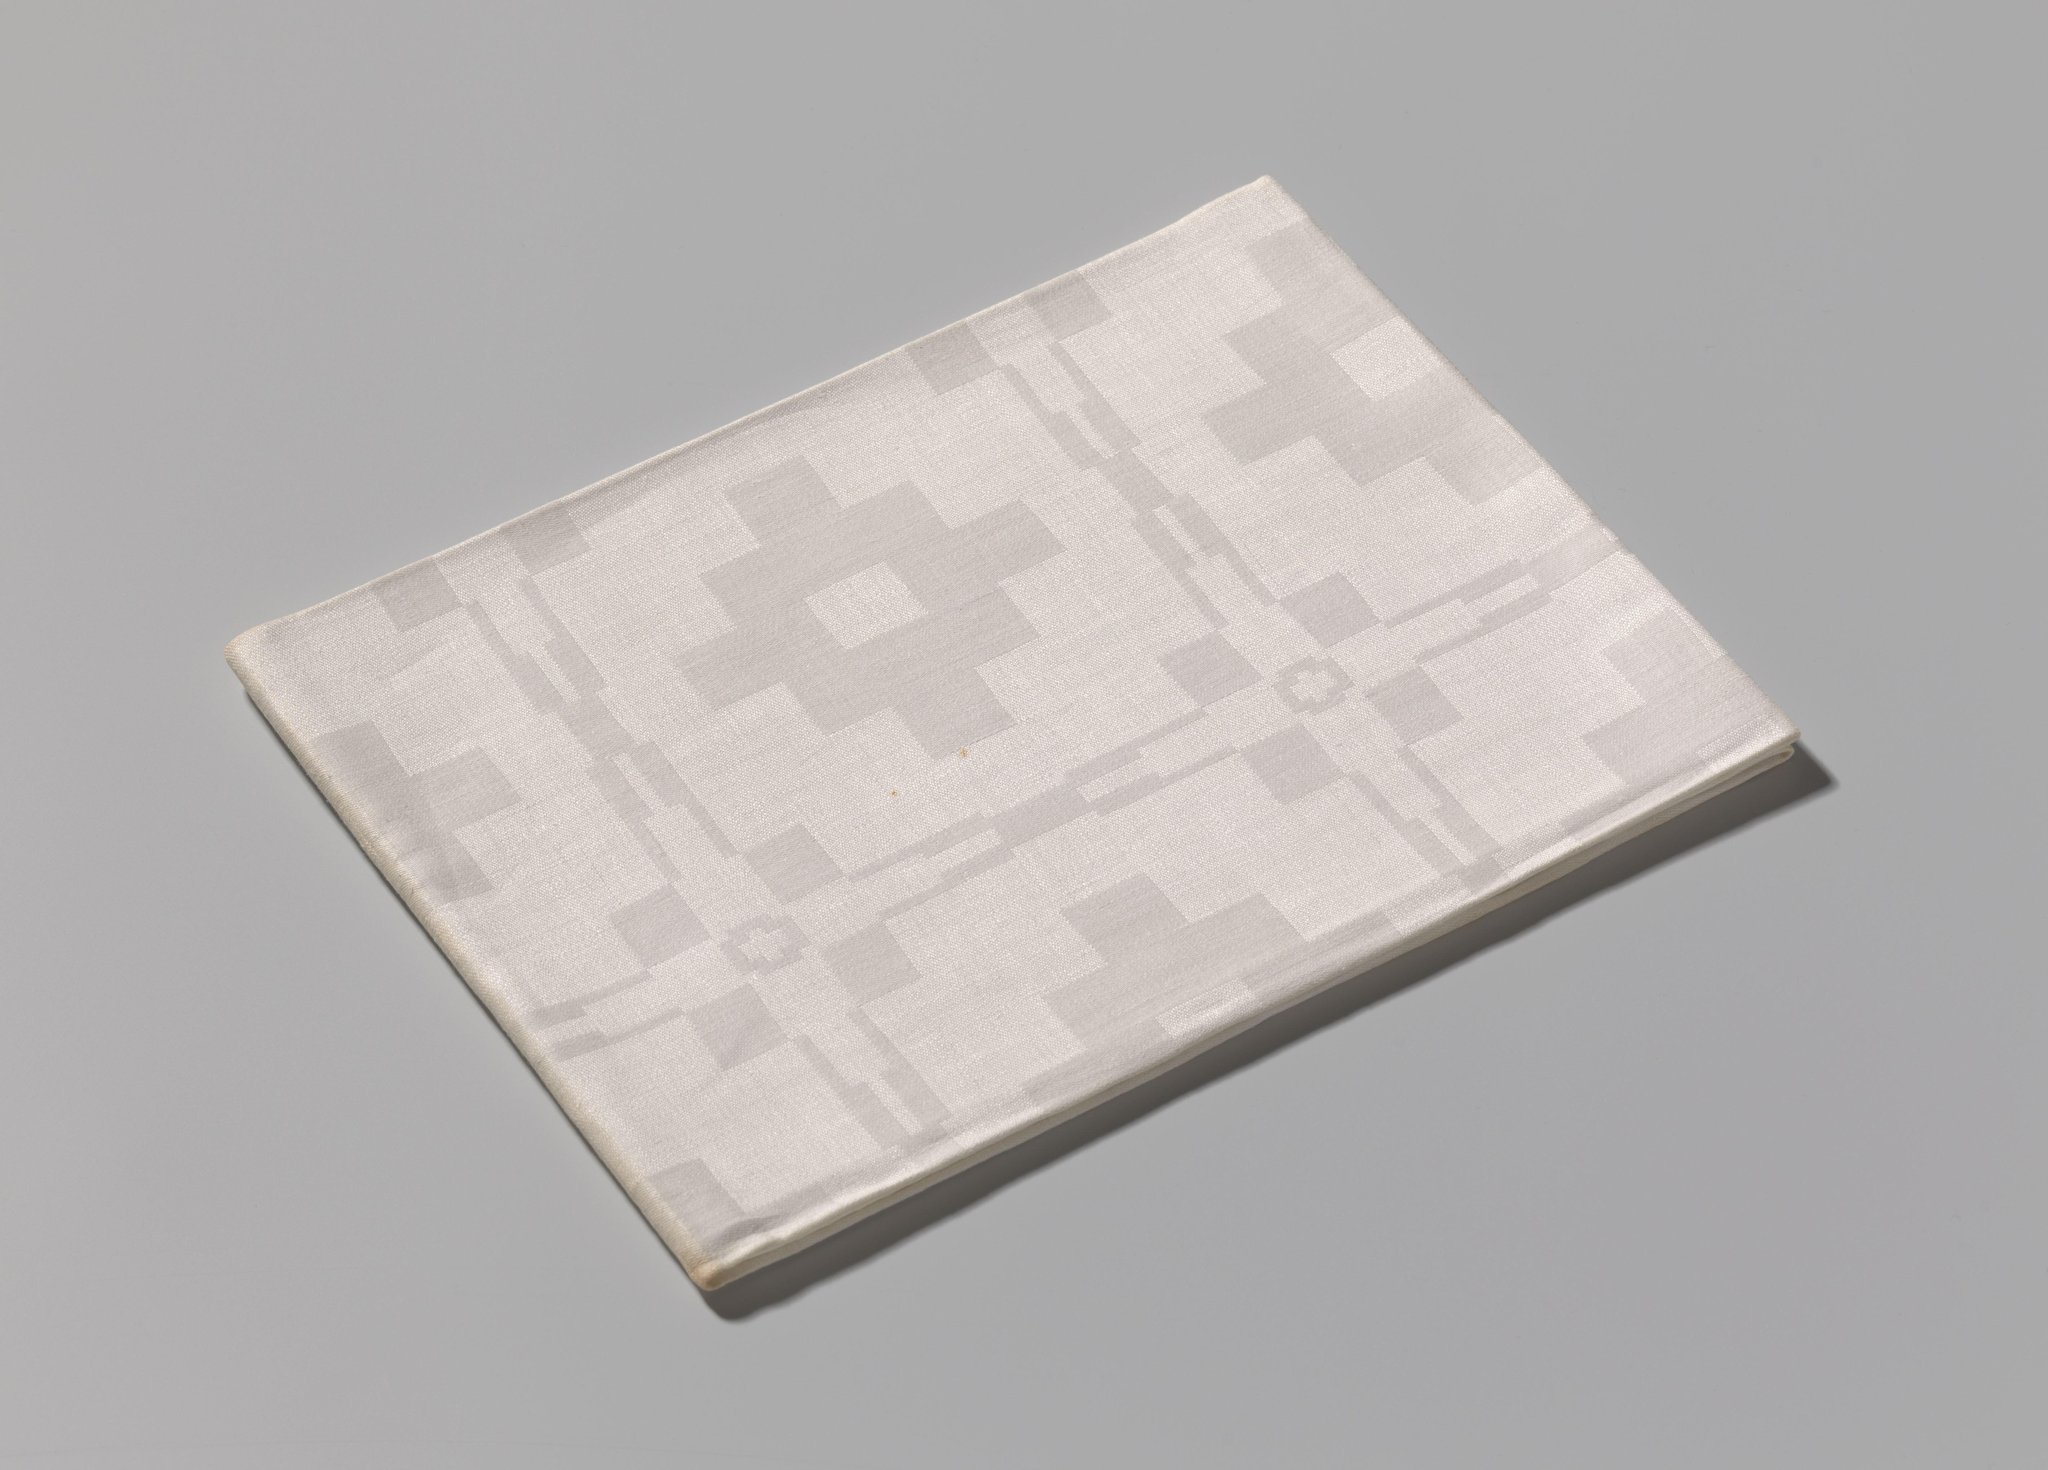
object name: napkin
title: Pellen met patroon 'uitgehouwen steen of hoekster'.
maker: Anonymous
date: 1800-1899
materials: linen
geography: netherlands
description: Servet van wti linnen met pellenpatroon 'uitgehouwen steen of hoekster' en randen, merk H 13.